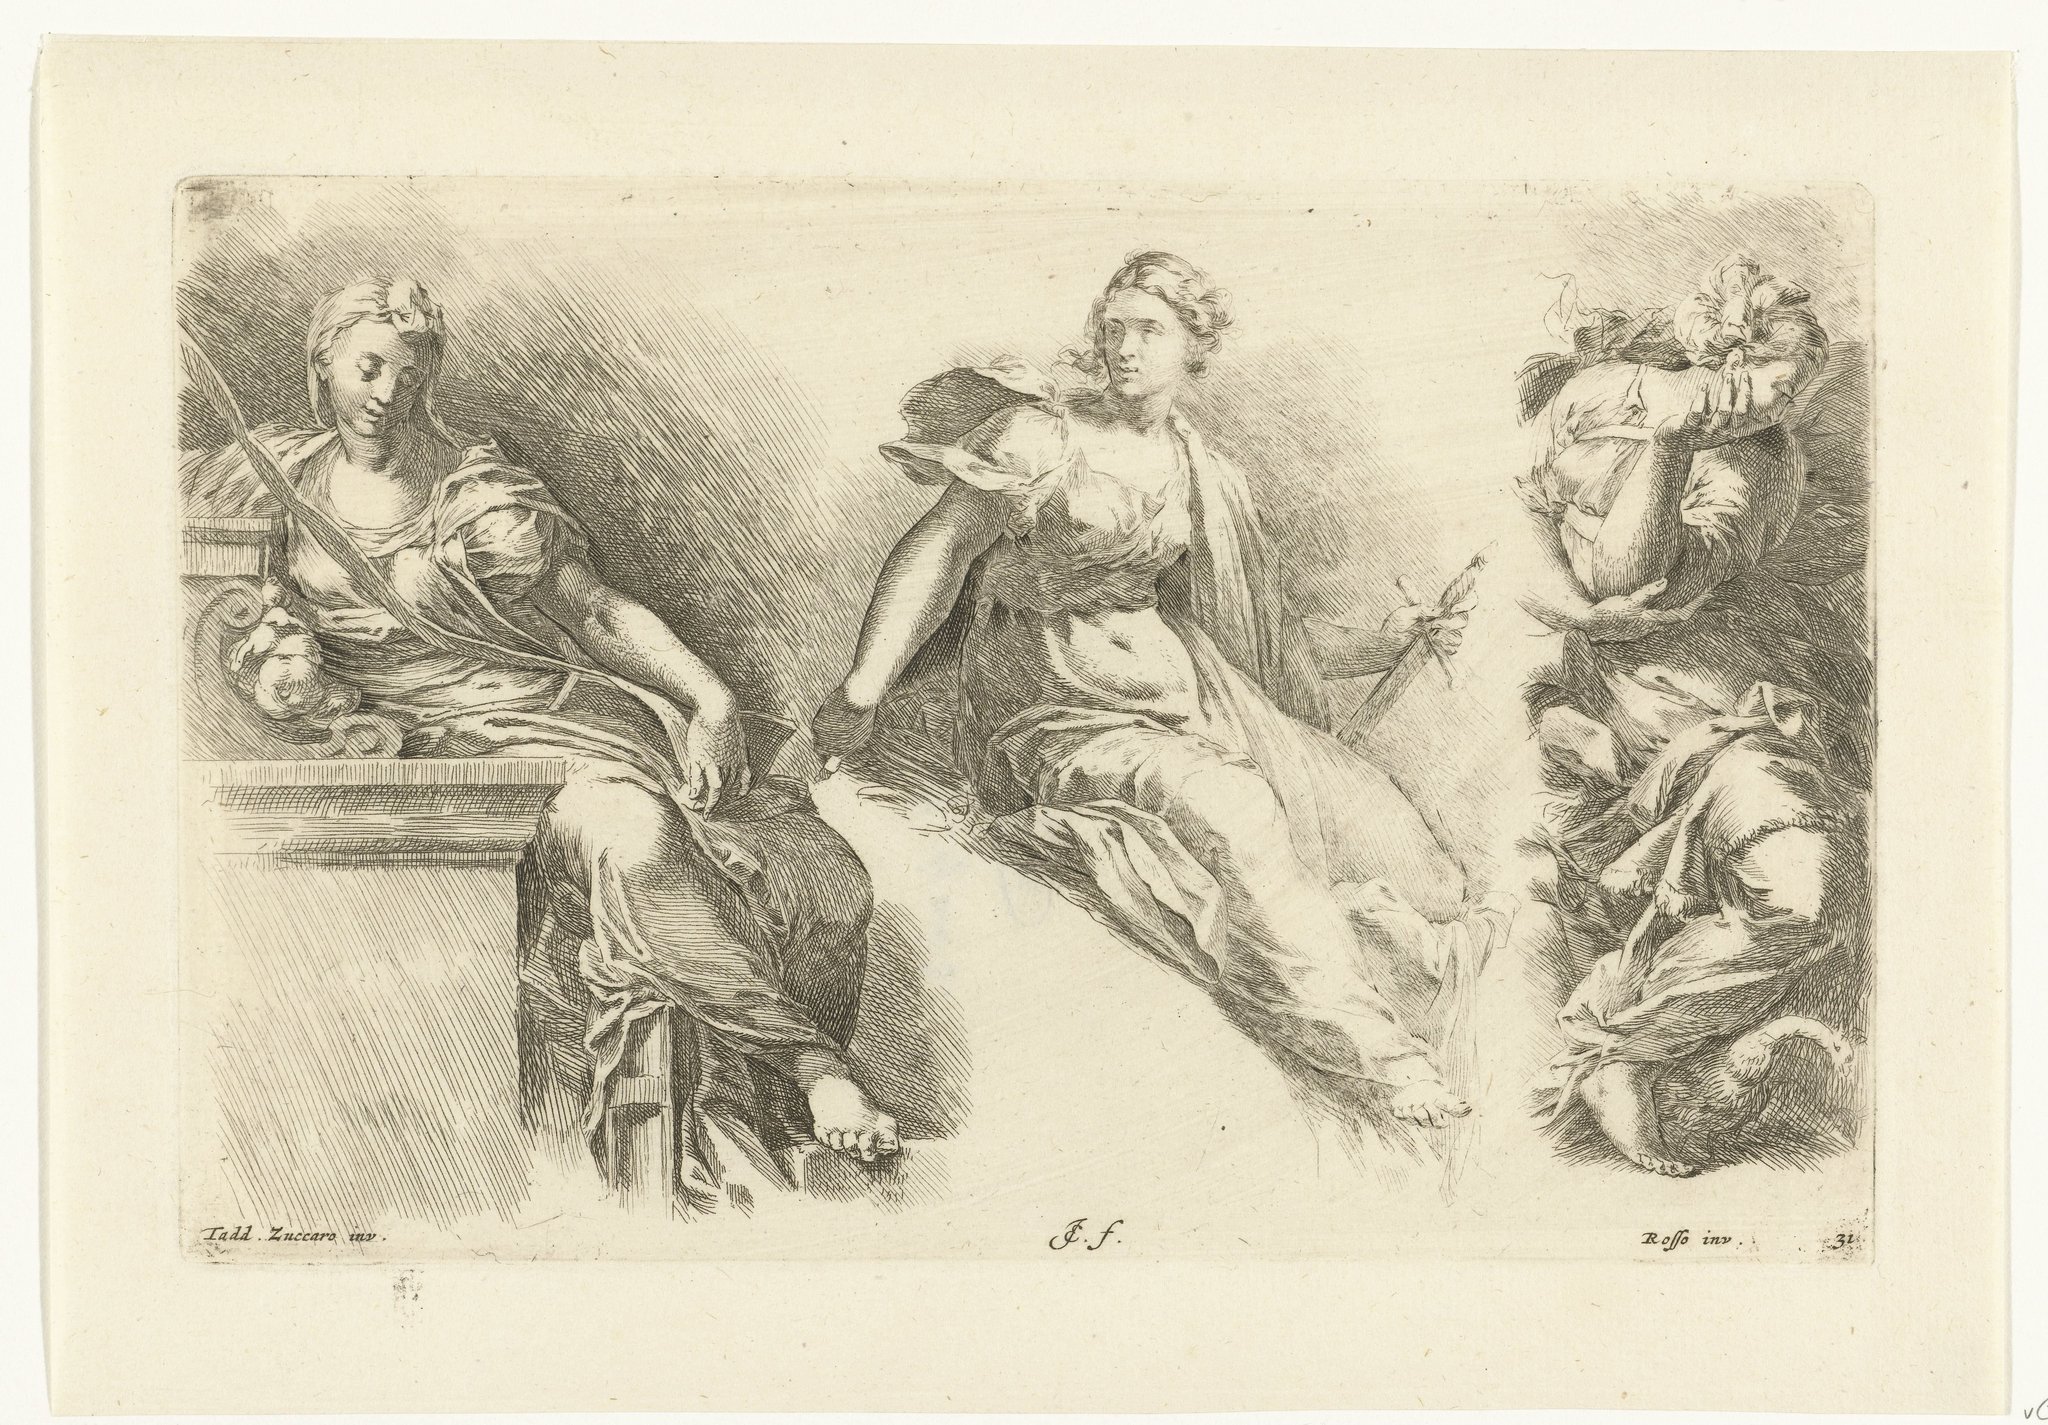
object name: print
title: Paradigmata graphices variorum artificum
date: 1668-1671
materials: paper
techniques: etching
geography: northern netherlands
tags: (story of) juno (hera), justice; 'forza alla giustitia sottoposta', 'giustitia', 'giustitia retta', 'giustitia rigorosa', 'impietà e violenza soggetta alla giustitia' (ripa), sibyls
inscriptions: collector's mark: Lugt 2228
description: Drie beelden van zittende vrouwen, links een sibille, in het midden de Rechtvaardigheid met haar zwaard, en rechts een vrouw met een pauw, mogelijk de godin Juno.